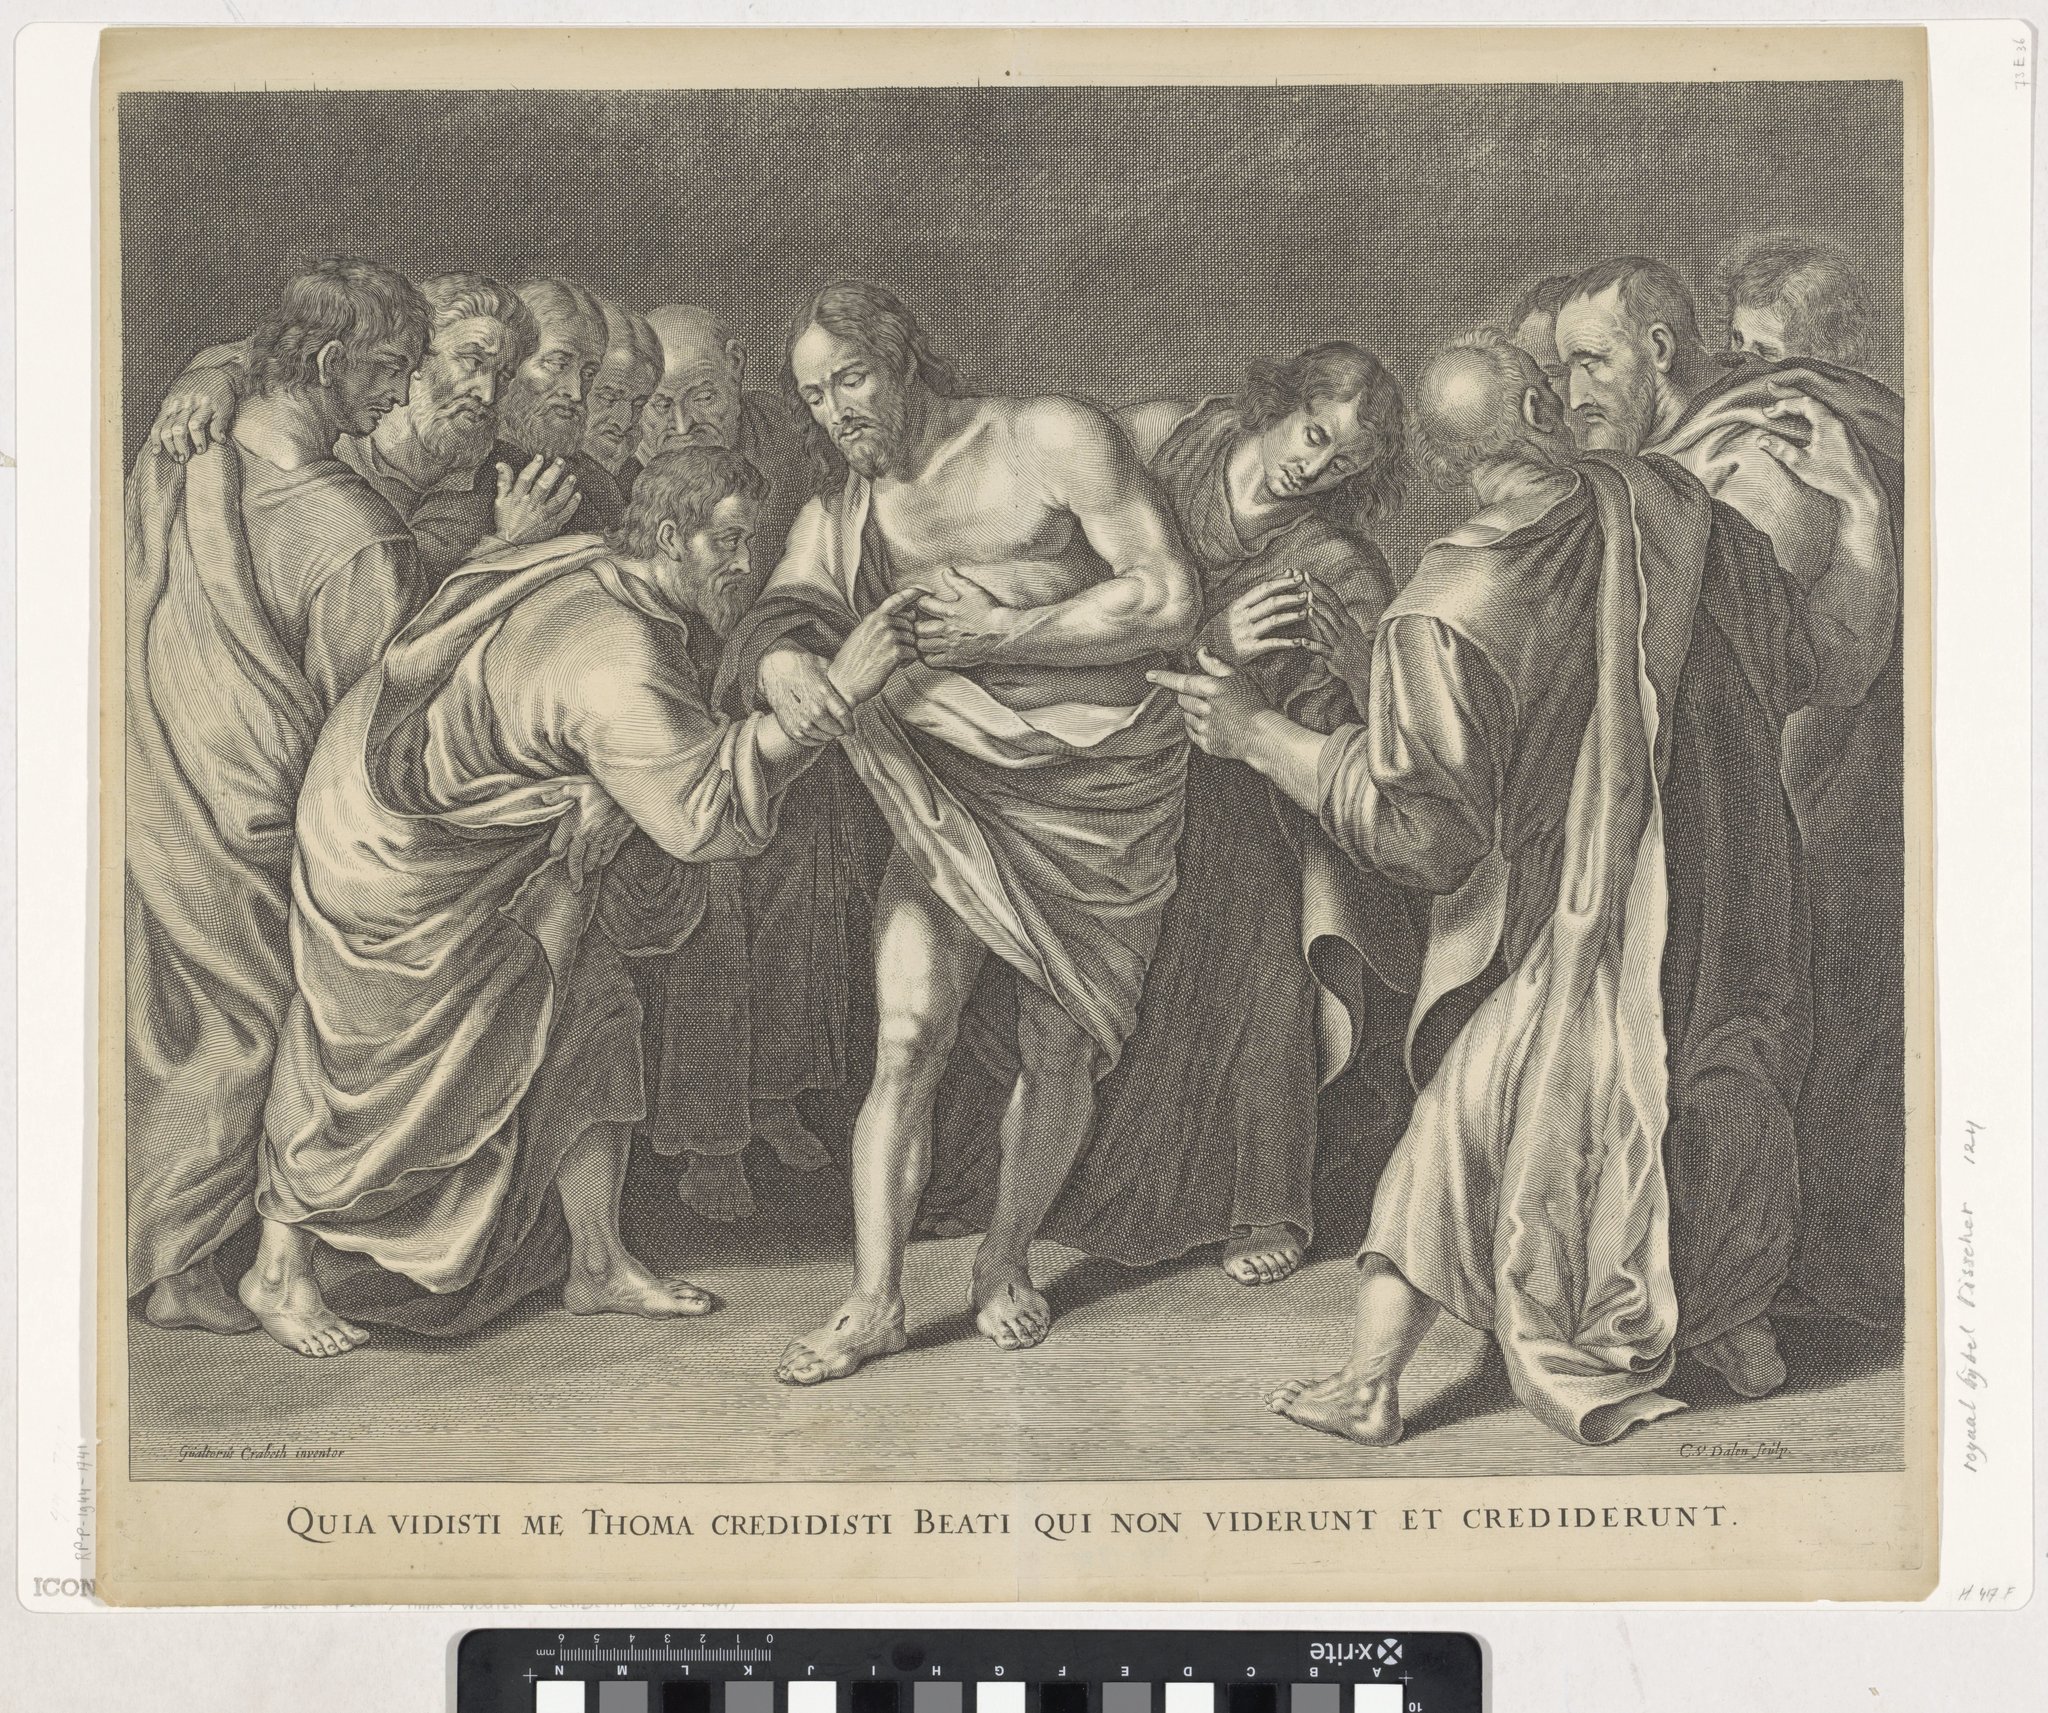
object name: print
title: Royaalbijbel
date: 1612-1665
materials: paper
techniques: engraving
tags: thomas touching or stretching out his hands to touch the wound in christ's side, sometimes christ leading thomas' hand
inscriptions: collector's mark: Lugt 2228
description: De Amsterdamse uitgever Claes Jansz. Visscher (II) produceerde vanaf de jaren ’30 van de zeventiende eeuw grote Bijbelse prenten op zogenaamd royaal-formaat papier (ca. 480 x 580 mm). Na zijn dood in 1652 zette zijn zoon Nicolaes Visscher (I) het bedrijf voort en zo ook de uitgave van Royaalbijbelprenten. Toen Nicolaes in 1679 overleed nam zijn zoon Nicolaes Visscher (II) het bedrijf over en gaf kort hierna, omstreeks 1680, een fondslijst uit. Hierin worden 130 prenten met Bijbelse voorstellingen op royaalpapier beschreven (zie documentatie J. van der Waals). Complete prentbijbels op royaal-formaat werden door vader en zoon Nicolaes Visscher uitgegeven onder de titel Historiae Sacrae Veteris et Novi Testamenti. De bladen werden echter ook los verkocht en konden worden gecombineerd met Royaalbijbel-prenten van andere uitgevers. Verschillende Amsterdamse uitgevers brachten namelijk ook bijbelprenten op royaal-formaat uit, onder wie Clement de Jonghe en Cornelis Danckerts. De door de firma Visscher uitgegeven prenten zijn veelal vervaardigd door anonieme prentmakers naar voorbeeld van verschillende zestiende- en zeventiende-eeuwse Bijbelse prenten en prentreeksen. Veelal moesten de composities worden aangepast aan het grotere en langgerekte royaal-formaat. Daarnaast zijn er ook grote bladen van bekende prentmakers zoals Jan van Londerseel, Pieter Nolpe, Jacques de Gheyn (II) en Jan Harmensz. Muller opgenomen in de categorie ‘Bybelsche Figuren, op Royaal-bladen’ in de fondslijst van Visscher. Prent mogelijk gebruikt in: Historiae Sacrae Veteris et Novi Testamenti (Royaalbijbel). Amsterdam: Nicolaes Visscher (I) en (II), [1652-1702]. In de fondslijst van Nicolaes Visscher II (ca. 1680) is het onderwerp van deze prent onder de titel 'Bybelsche Figuren, op Royaal-bladen. bestaande uyt de volgende historien.' als volgt genummerd: 124.